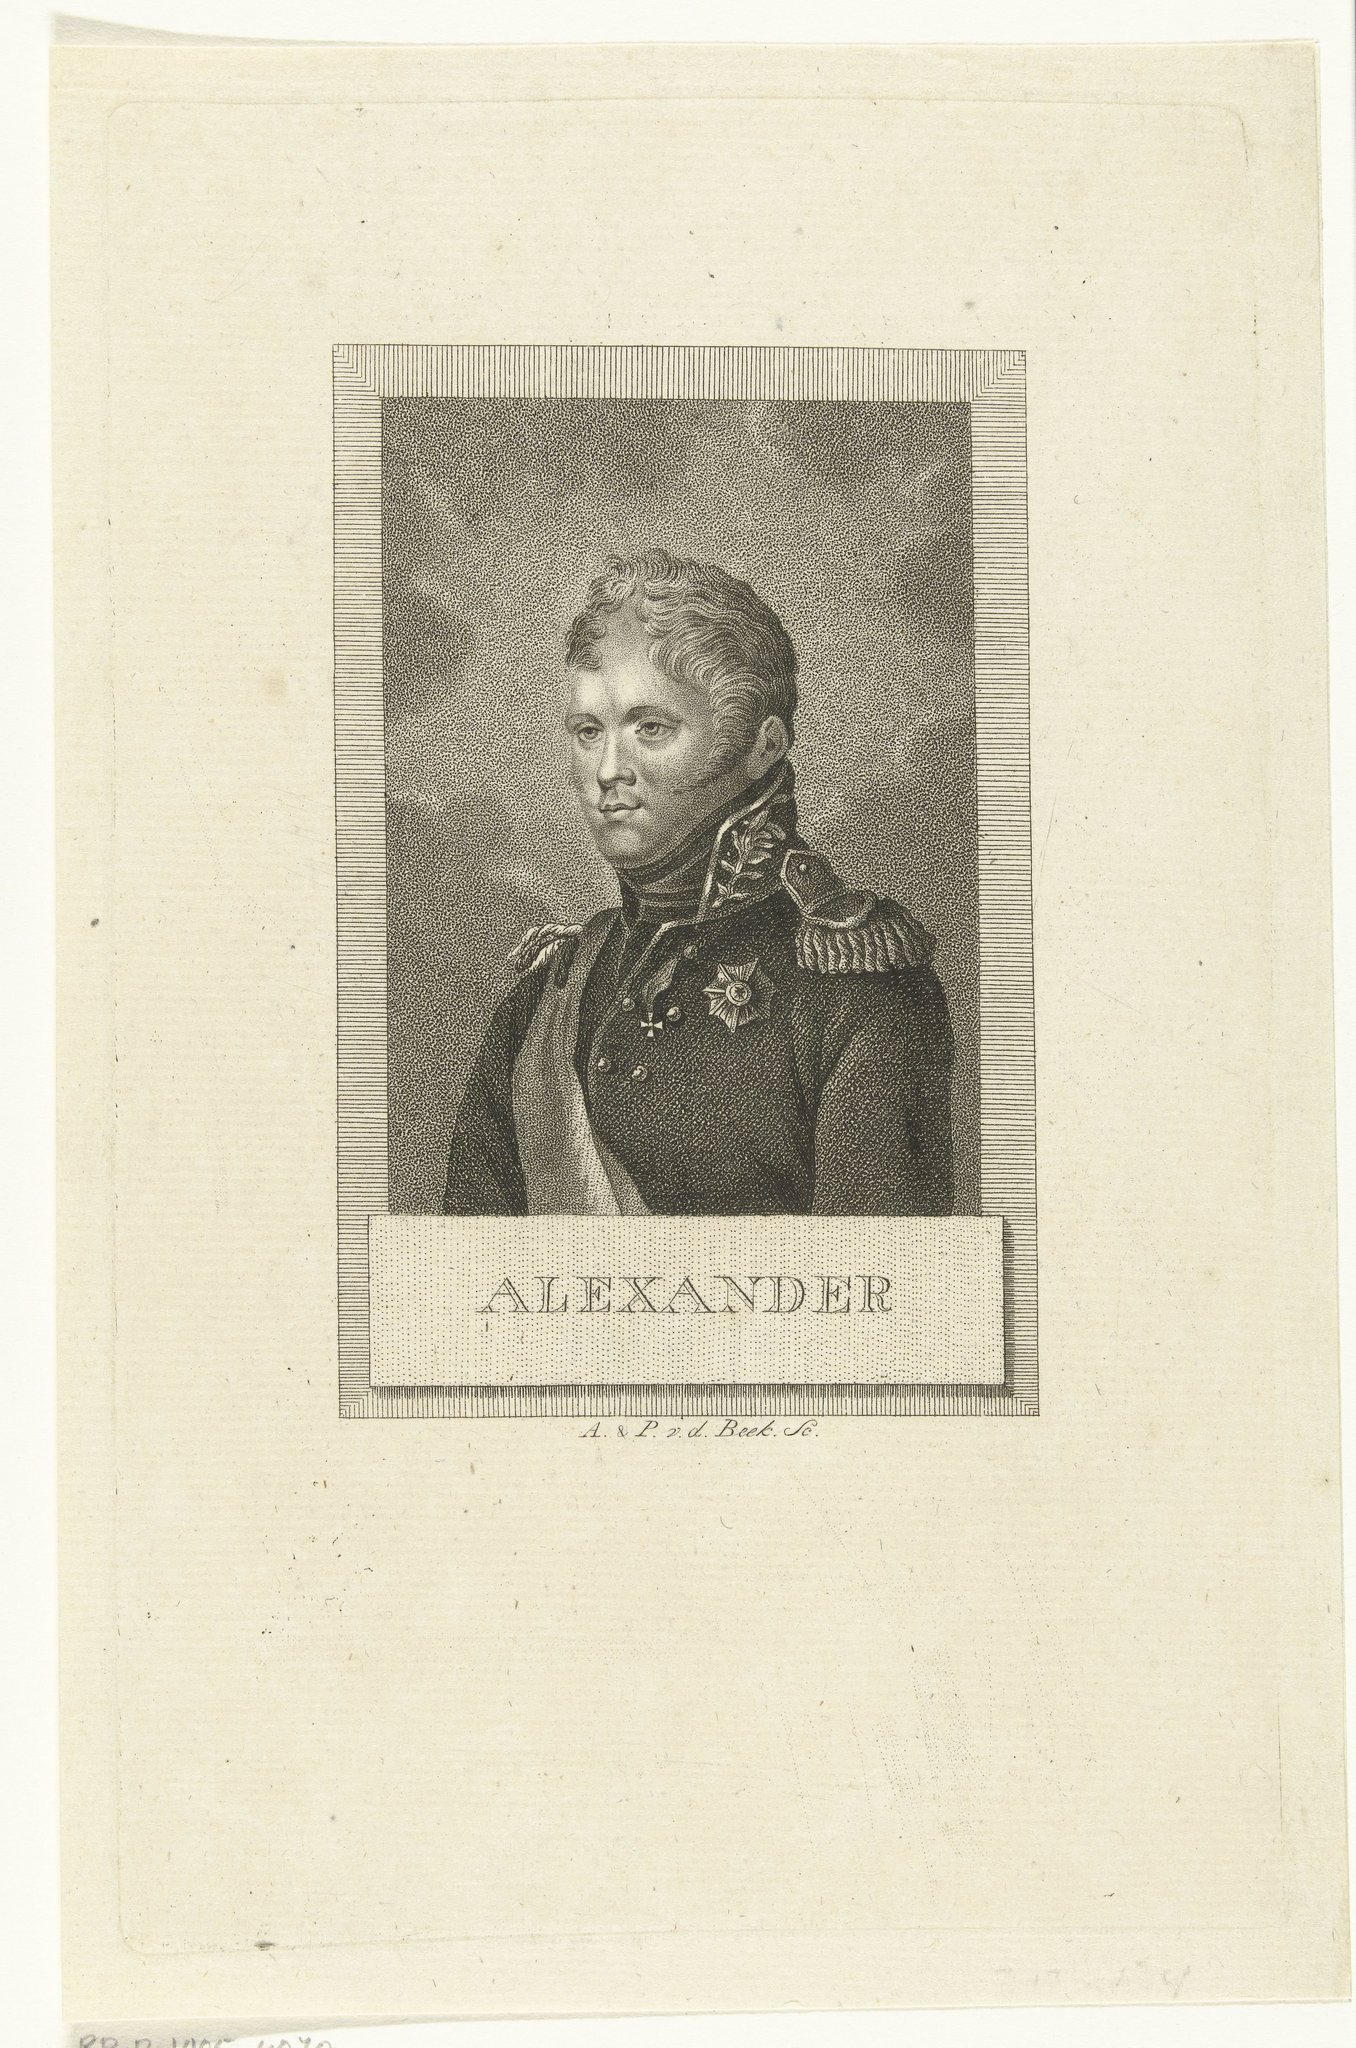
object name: print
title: Portret van tsaar Alexander I van Rusland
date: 1795-1821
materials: paper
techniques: aquatint, etching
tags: alexander i (tsaar van rusland)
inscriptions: collector's mark: Lugt 2228